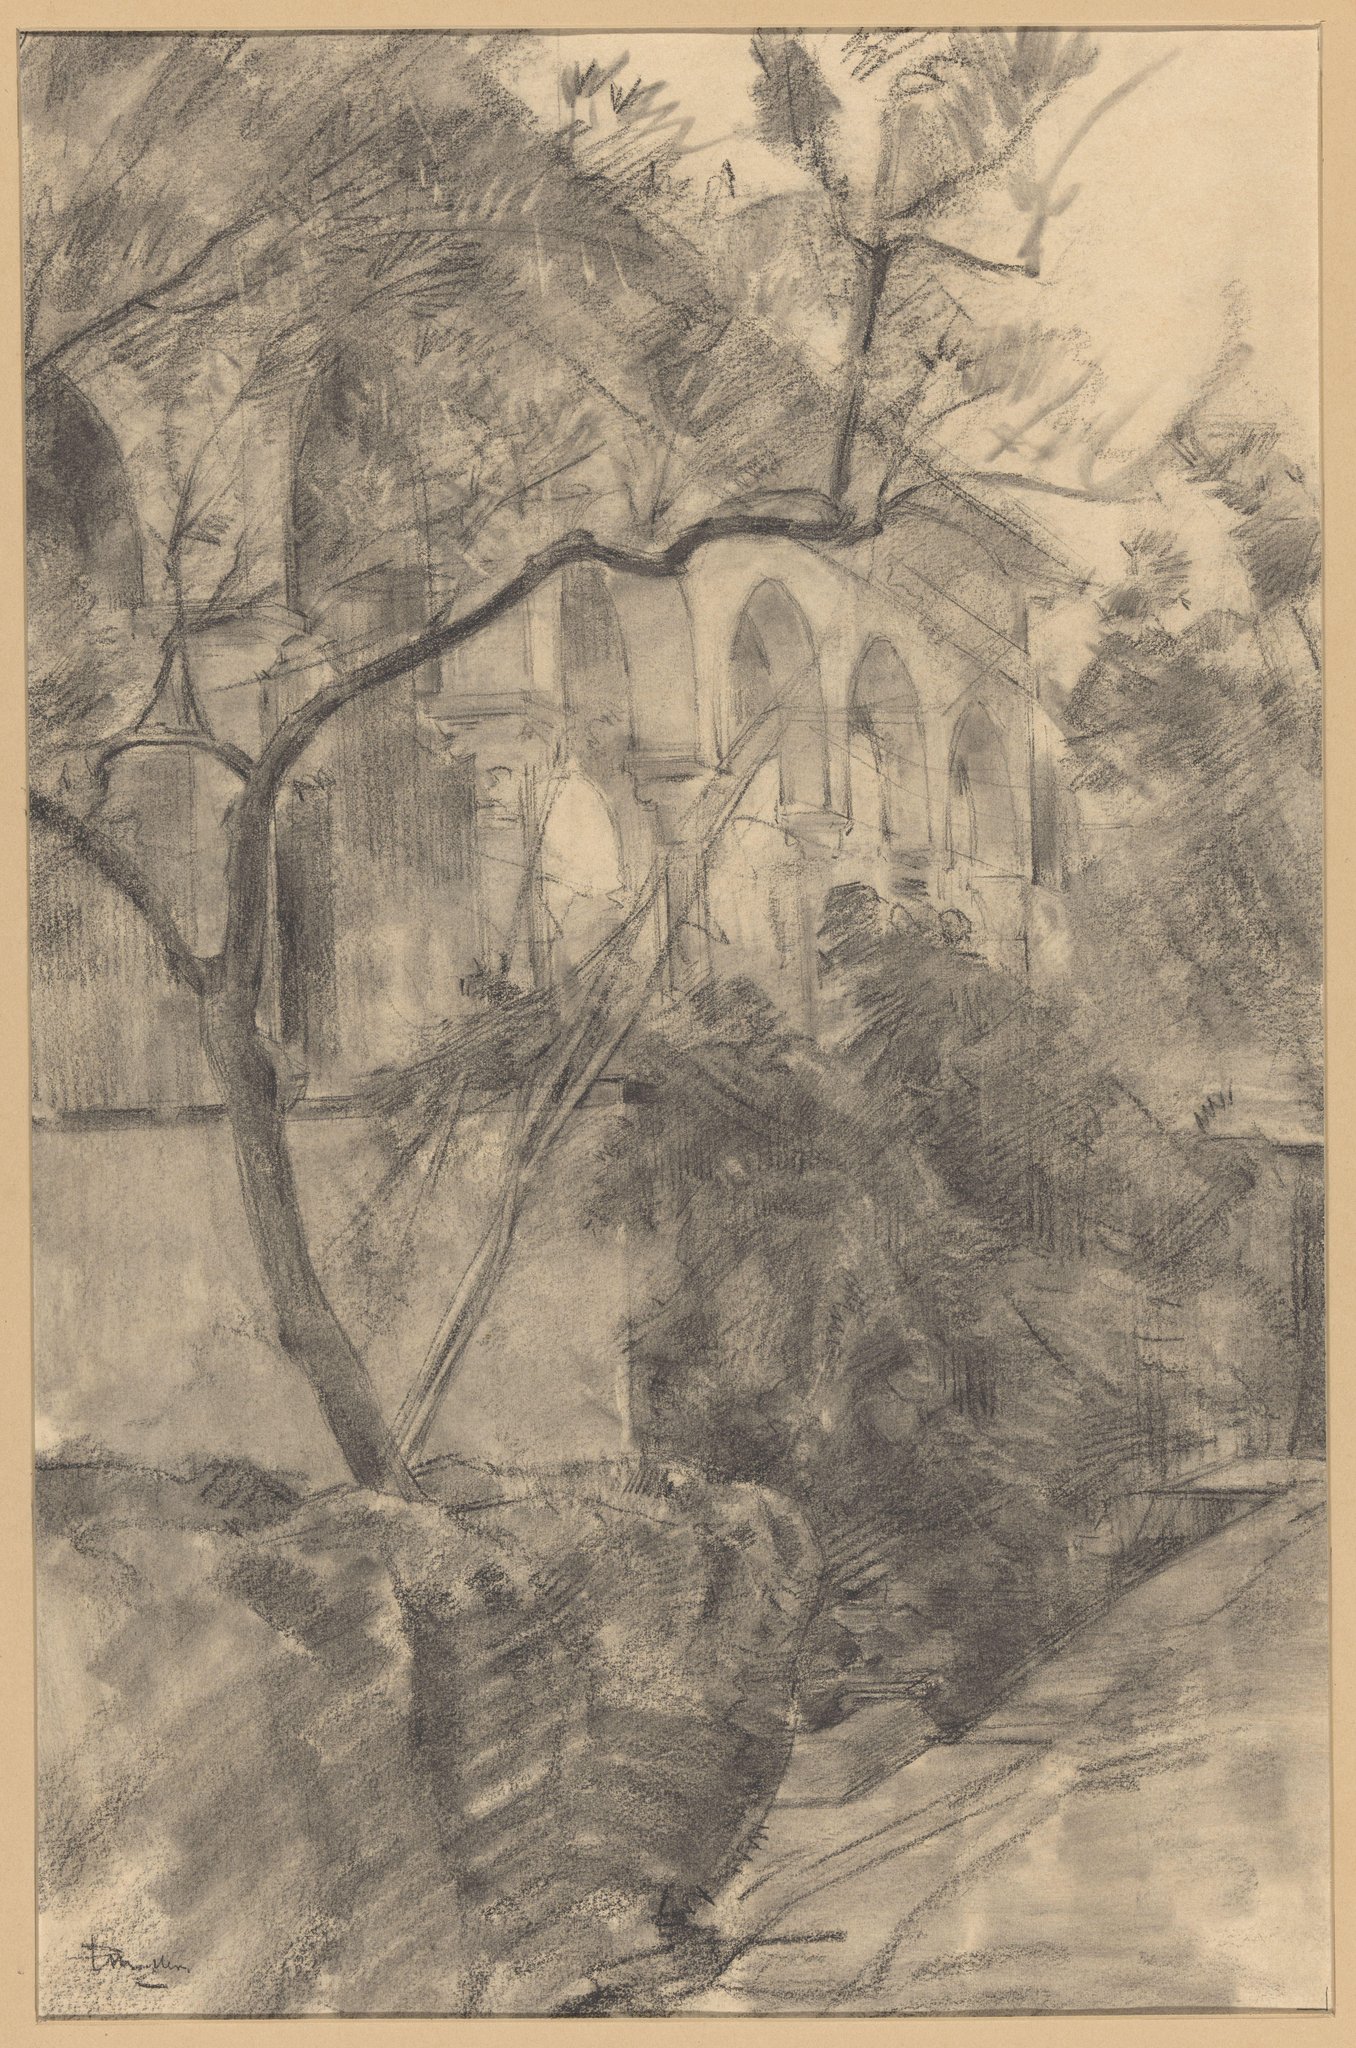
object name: drawing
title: Paviljoen van Karel V in het Koninklijk Paleis te Sevilla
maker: gerard muller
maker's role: draughtsman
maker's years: 1861-1929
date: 1871-1903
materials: chalk, paper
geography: sevilla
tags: palace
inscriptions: collector's mark: Lugt 2228, label: ‘23 Alcázar . Sevilla/ Pavilloen Karel V.’